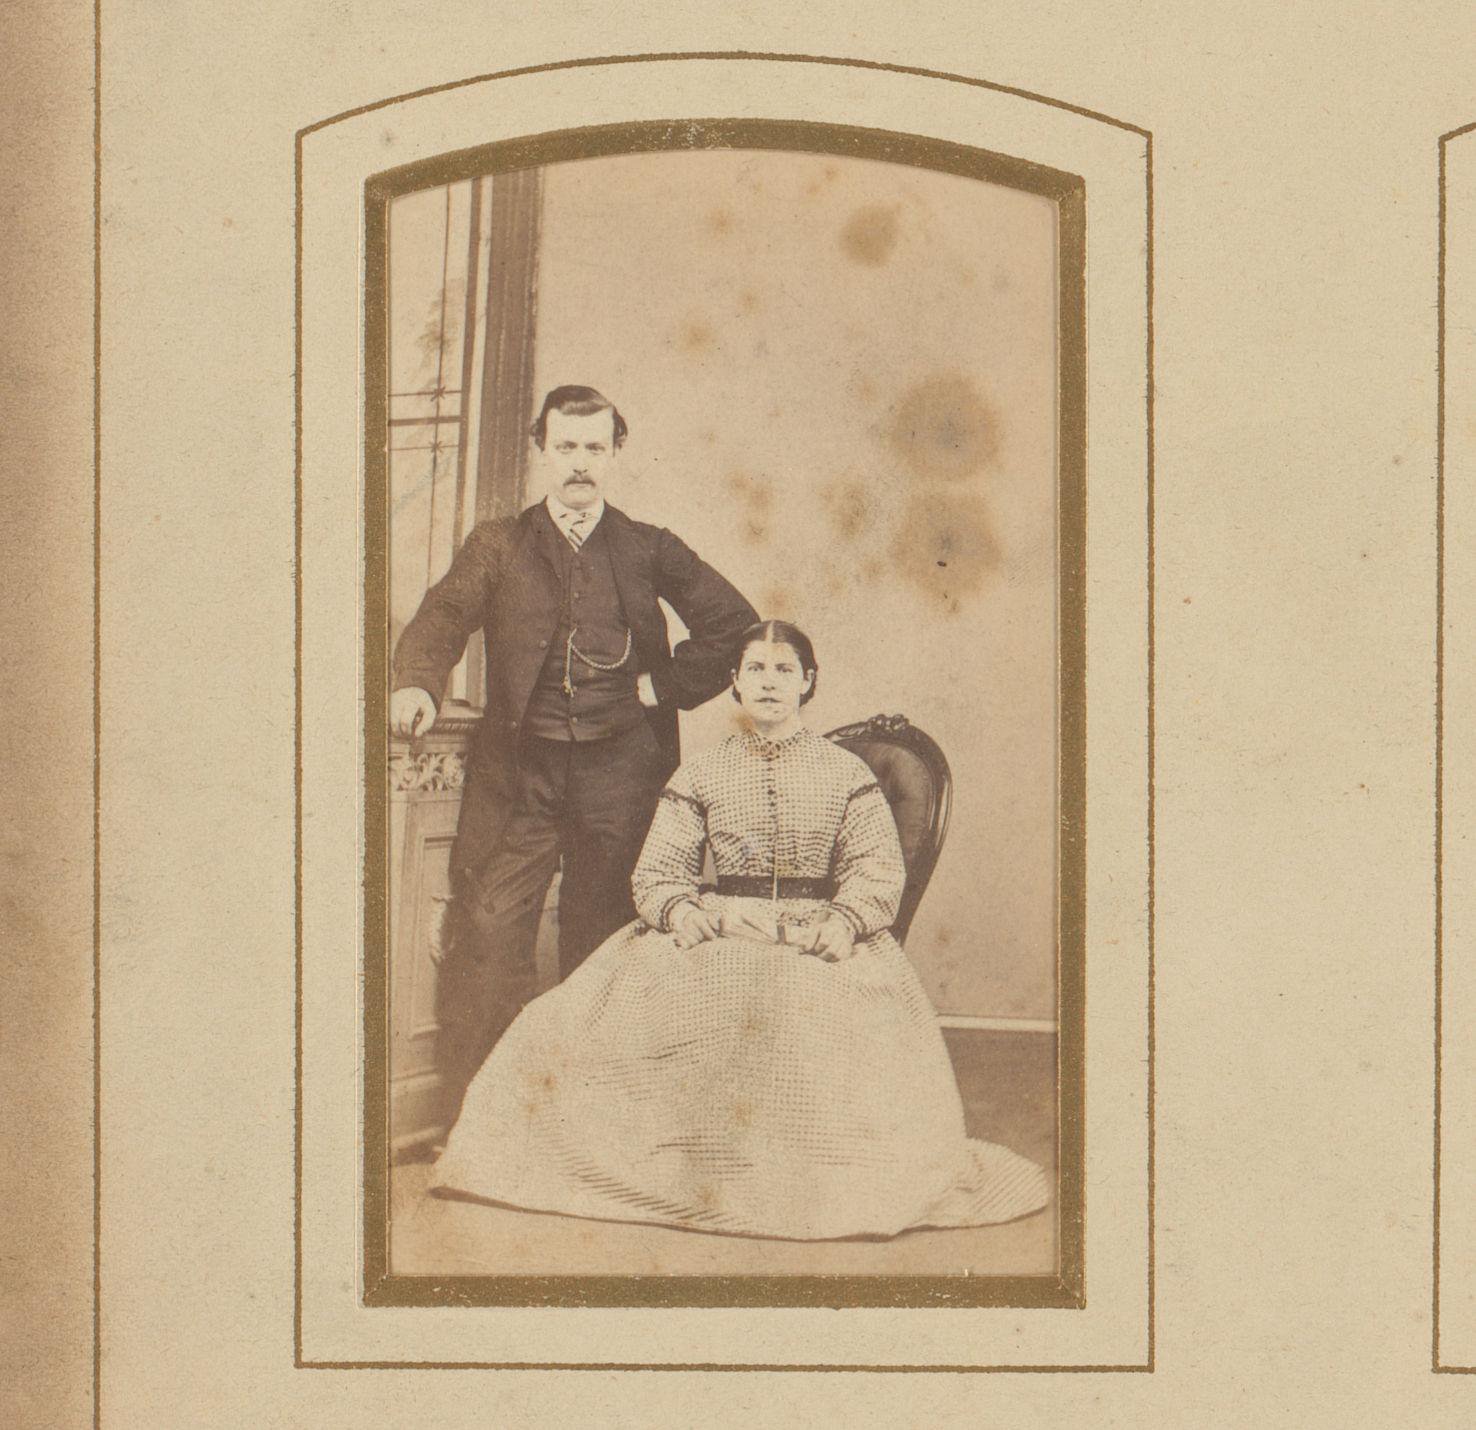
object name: carte de visite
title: Portret van een man en vrouw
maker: j. oliver (fotograaf)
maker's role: fotograaf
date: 1860-1900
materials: cardboard, photographic support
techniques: albumen print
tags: sitting figure, adult woman, adult man, historical persons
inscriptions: inscription: ‘J. Oliver/ Town-Hall/ Sowerby Bridge’